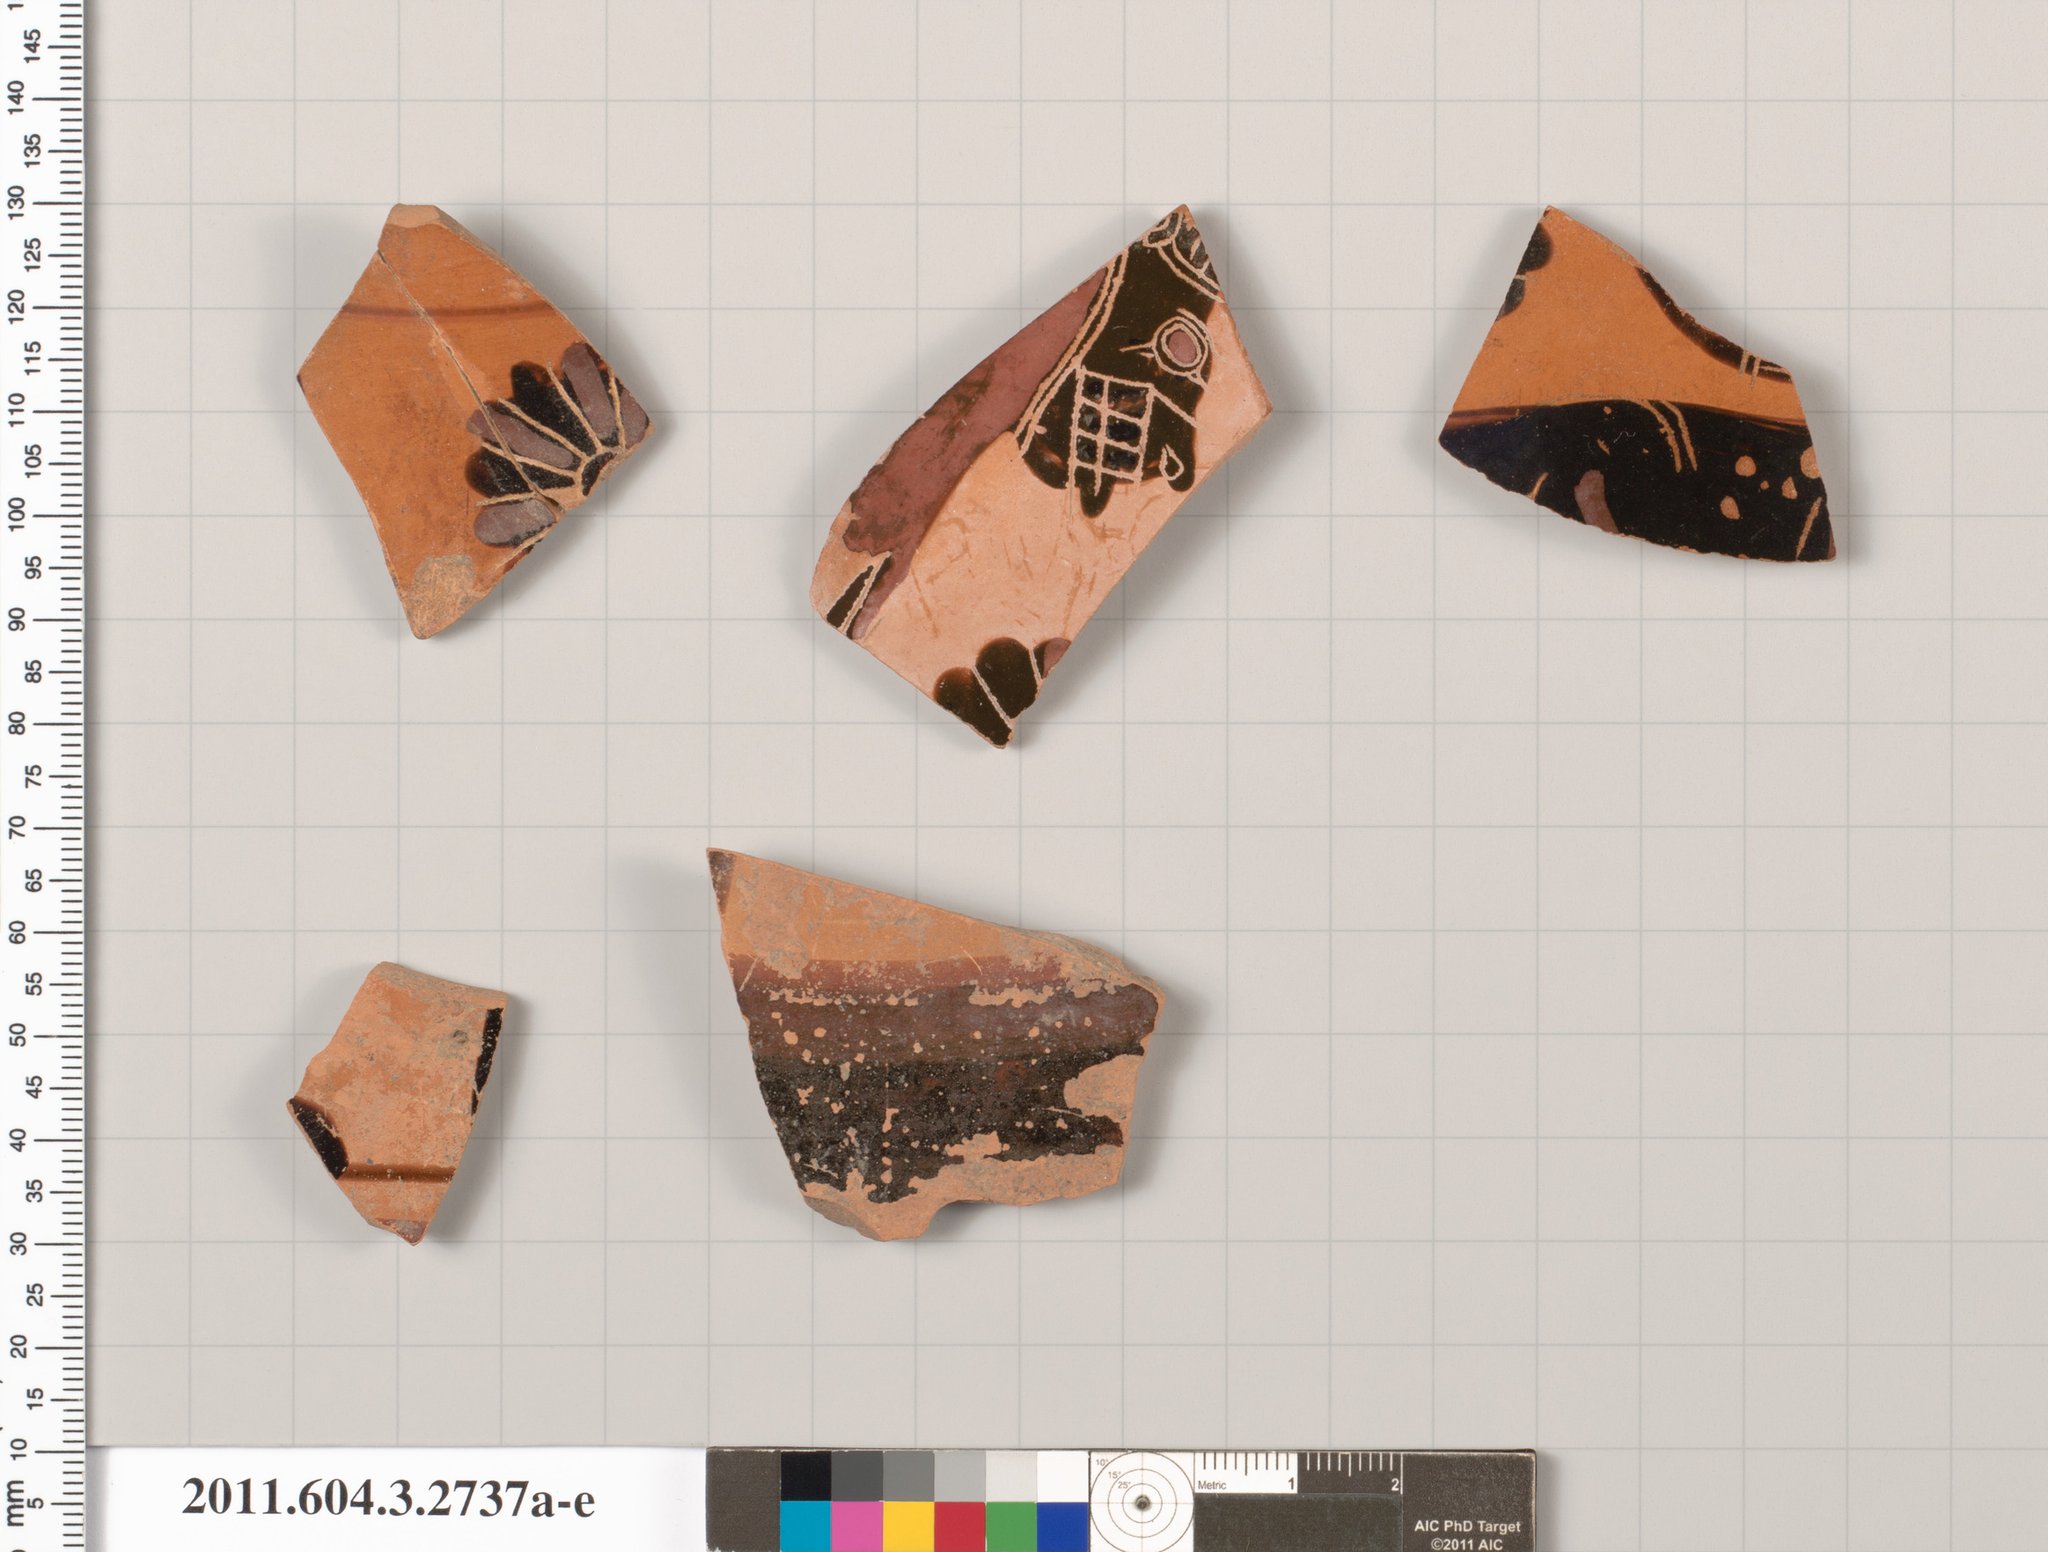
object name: olpe fragment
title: Terracotta fragments of a trefoil olpe (jug)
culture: greek, attic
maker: gorgon painter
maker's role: artist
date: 500-476 BCE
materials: terracotta